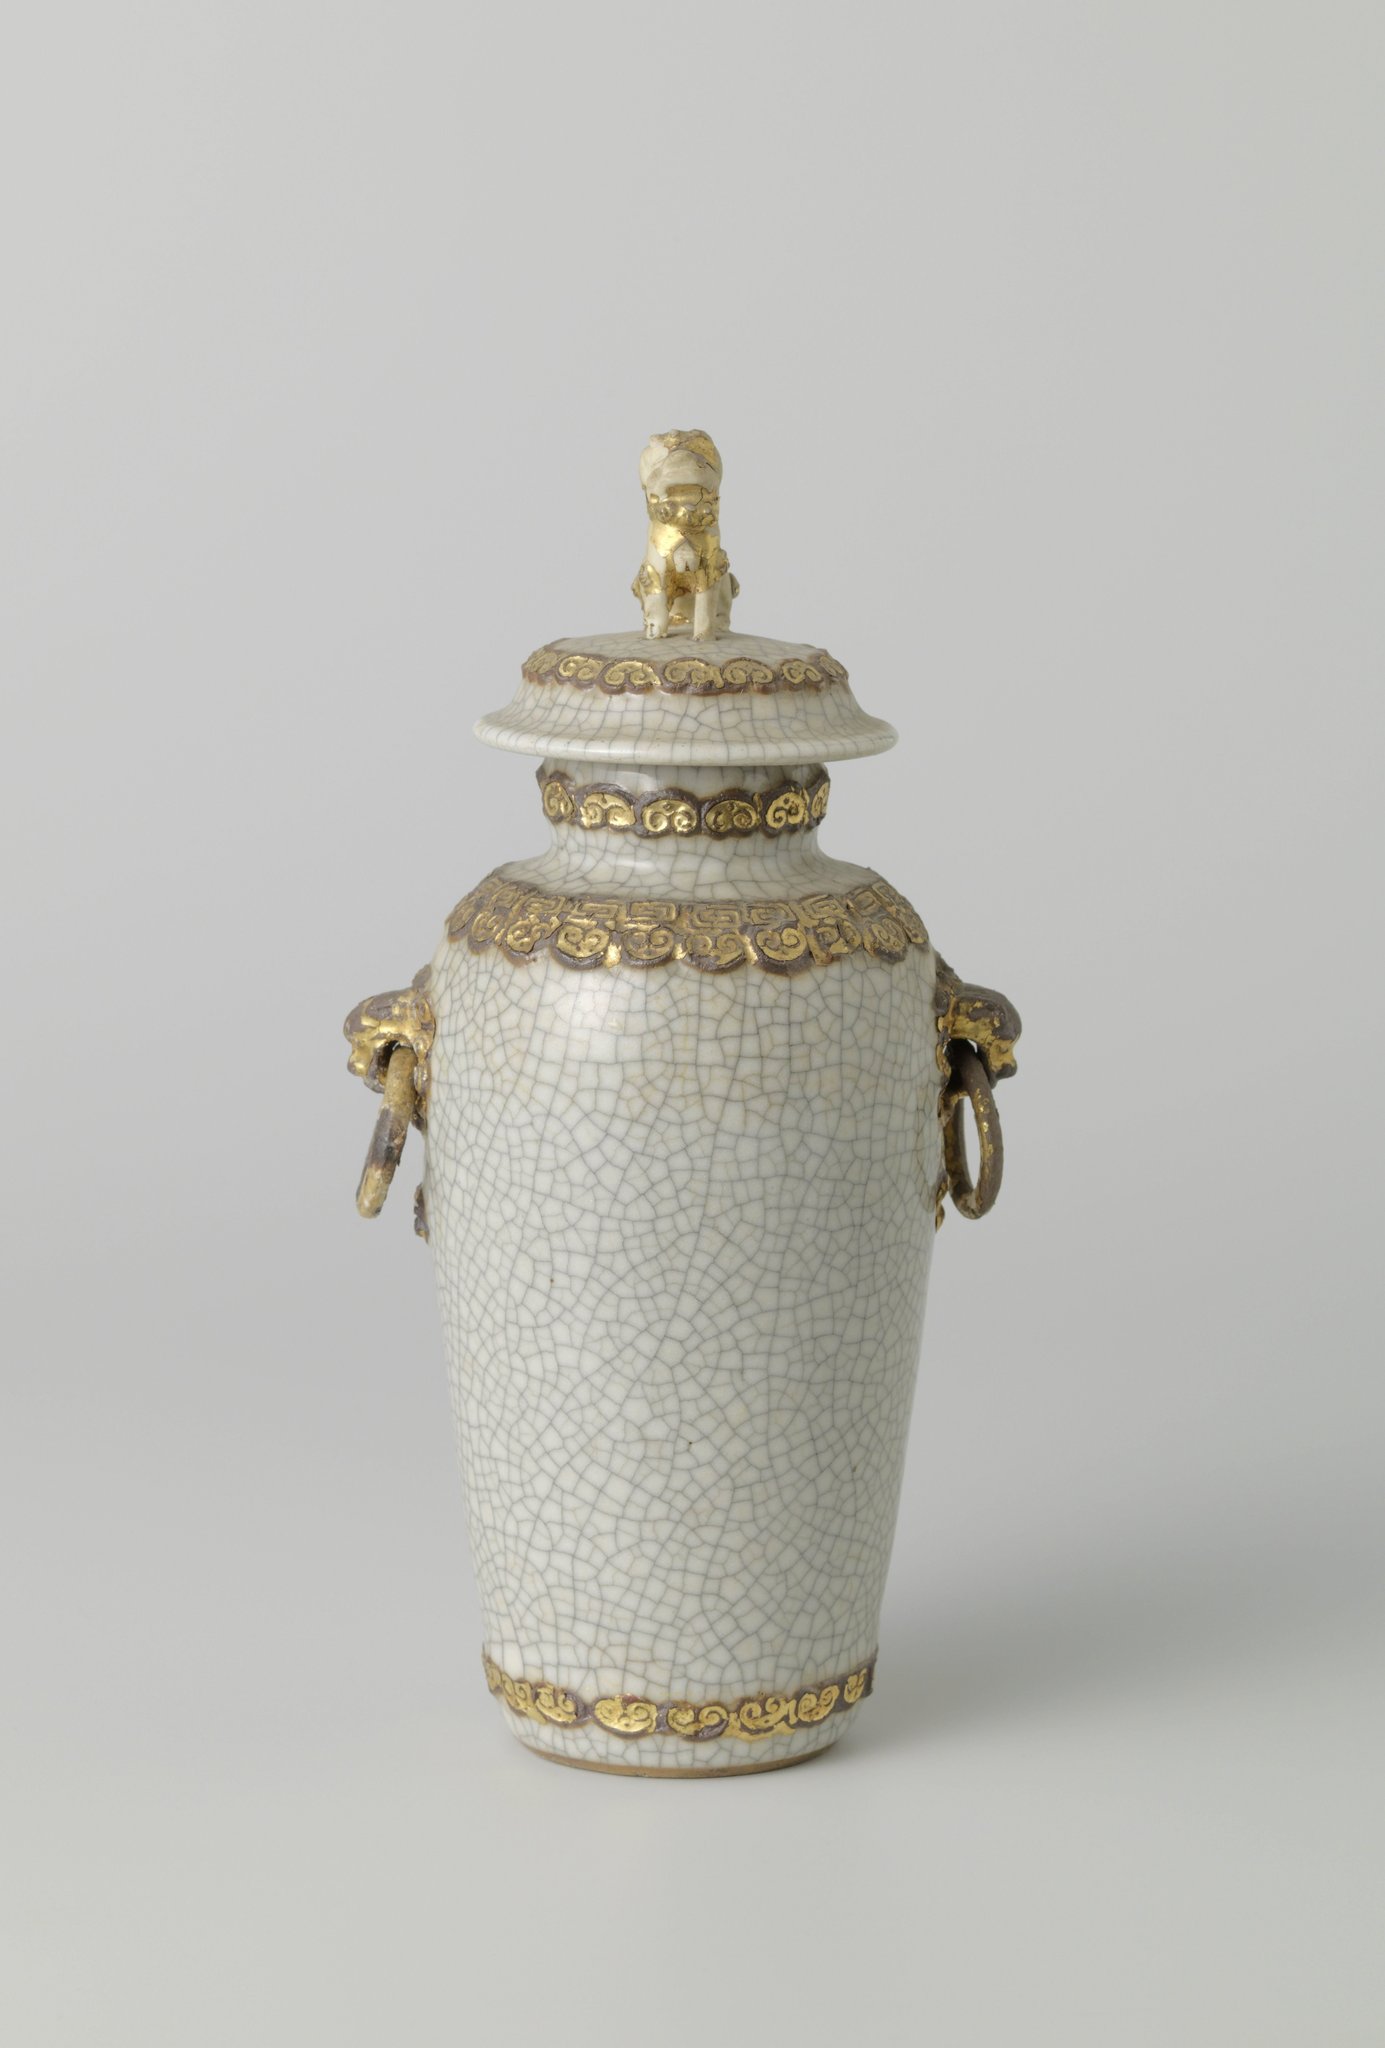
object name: covered jar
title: Covered jar with monster heads and gilded bands with ruyi motif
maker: Anonymous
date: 1750-1799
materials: glaze, gold, porcelain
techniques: firing, forming, gilding, turning, vitrification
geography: china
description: AK-NM-6370 Twee kleine dekselvazen • Monochromen • Onderdeel van Royers porseleincollectie • Gepubliceerd: Jörg 1997, nr. 269 Voor een bespreking van dit gecraqueleerde porselein, zie de toelichting bij AK-NM-6371. Gerelateerde gemonteerde stukken zijn afgebeeld door Lunsingh Scheurleer [LS 1980, afb. 305 en 545]. Het eerste stuk is van een aanmerkelijk betere kwaliteit dan Royers dekselvazen; de tweede (in de collectie van Singraven, Denekamp) zeker niet. Dat heeft een laat 19de-eeuws montuur en het porselein kreeg als datering van Scheurleer ‘laat 18de eeuw of later’. De schouder is nog iets hoger dan bij Royers dekselvaasjes. Kortom: voorlopig is het nog niet mogelijk met zekerheid te zeggen of deze stukken 18de-eeuws (en dus waarschijnlijk van Royer) of 19de-eeuws zijn (en dan waren ze niet van Royer,maar zijn ze vóór 1876 bij diens collectie gevoegd in het Koninklijk kabimet van Zeldzaamheden). Bronnen: Daniel François Lunsingh Scheurleer, Chinesisches und japanisches Porzellan in europäischen Fassungen, Braunschweig, 1980. Christiaan J.A. Jörg, Chinese ceramics in the collection of the Rijksmuseum, Amsterdam: the Ming and Qing dynasties, Londen, 1997.